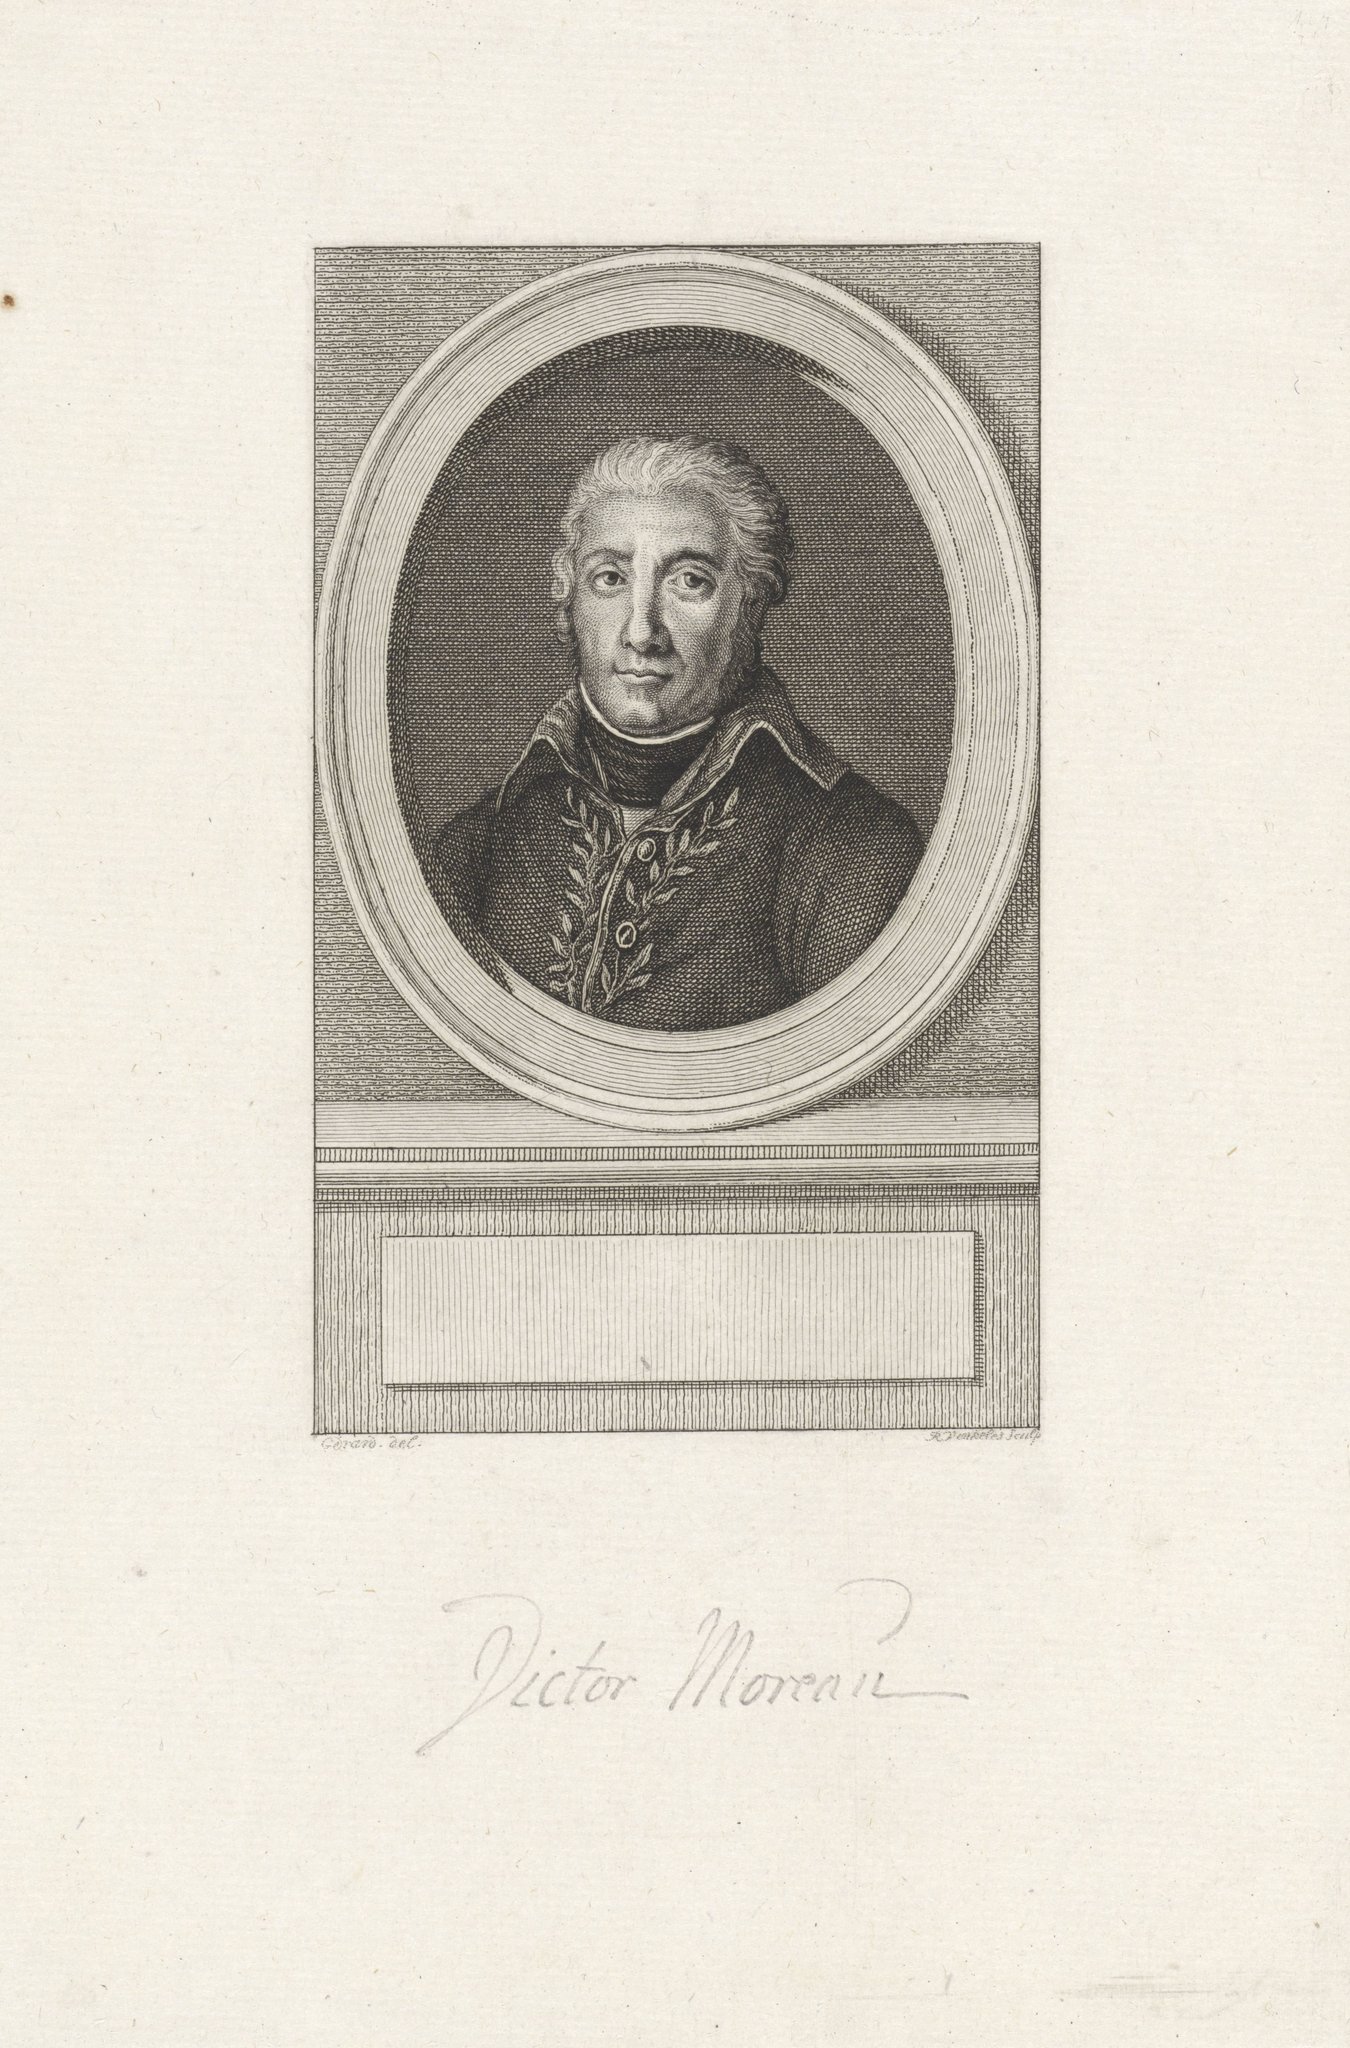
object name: print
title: Portret van Jean Victor Marie Moreau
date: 1786-1809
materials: paper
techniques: engraving, etching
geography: amsterdam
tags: morlaix, militair, generaal, jean victor marie moreau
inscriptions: collector's mark: Lugt 240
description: Latere staat prent vermoedelijk gebruikt als boekillustratie in: Wagenaar, Jan. Vaderlandsche historie, (...) ten vervolge van Wagenaars Vaderlandsche historie. Dl. 1-43. Amsterdam: Johannes Allart, 1786-1809.